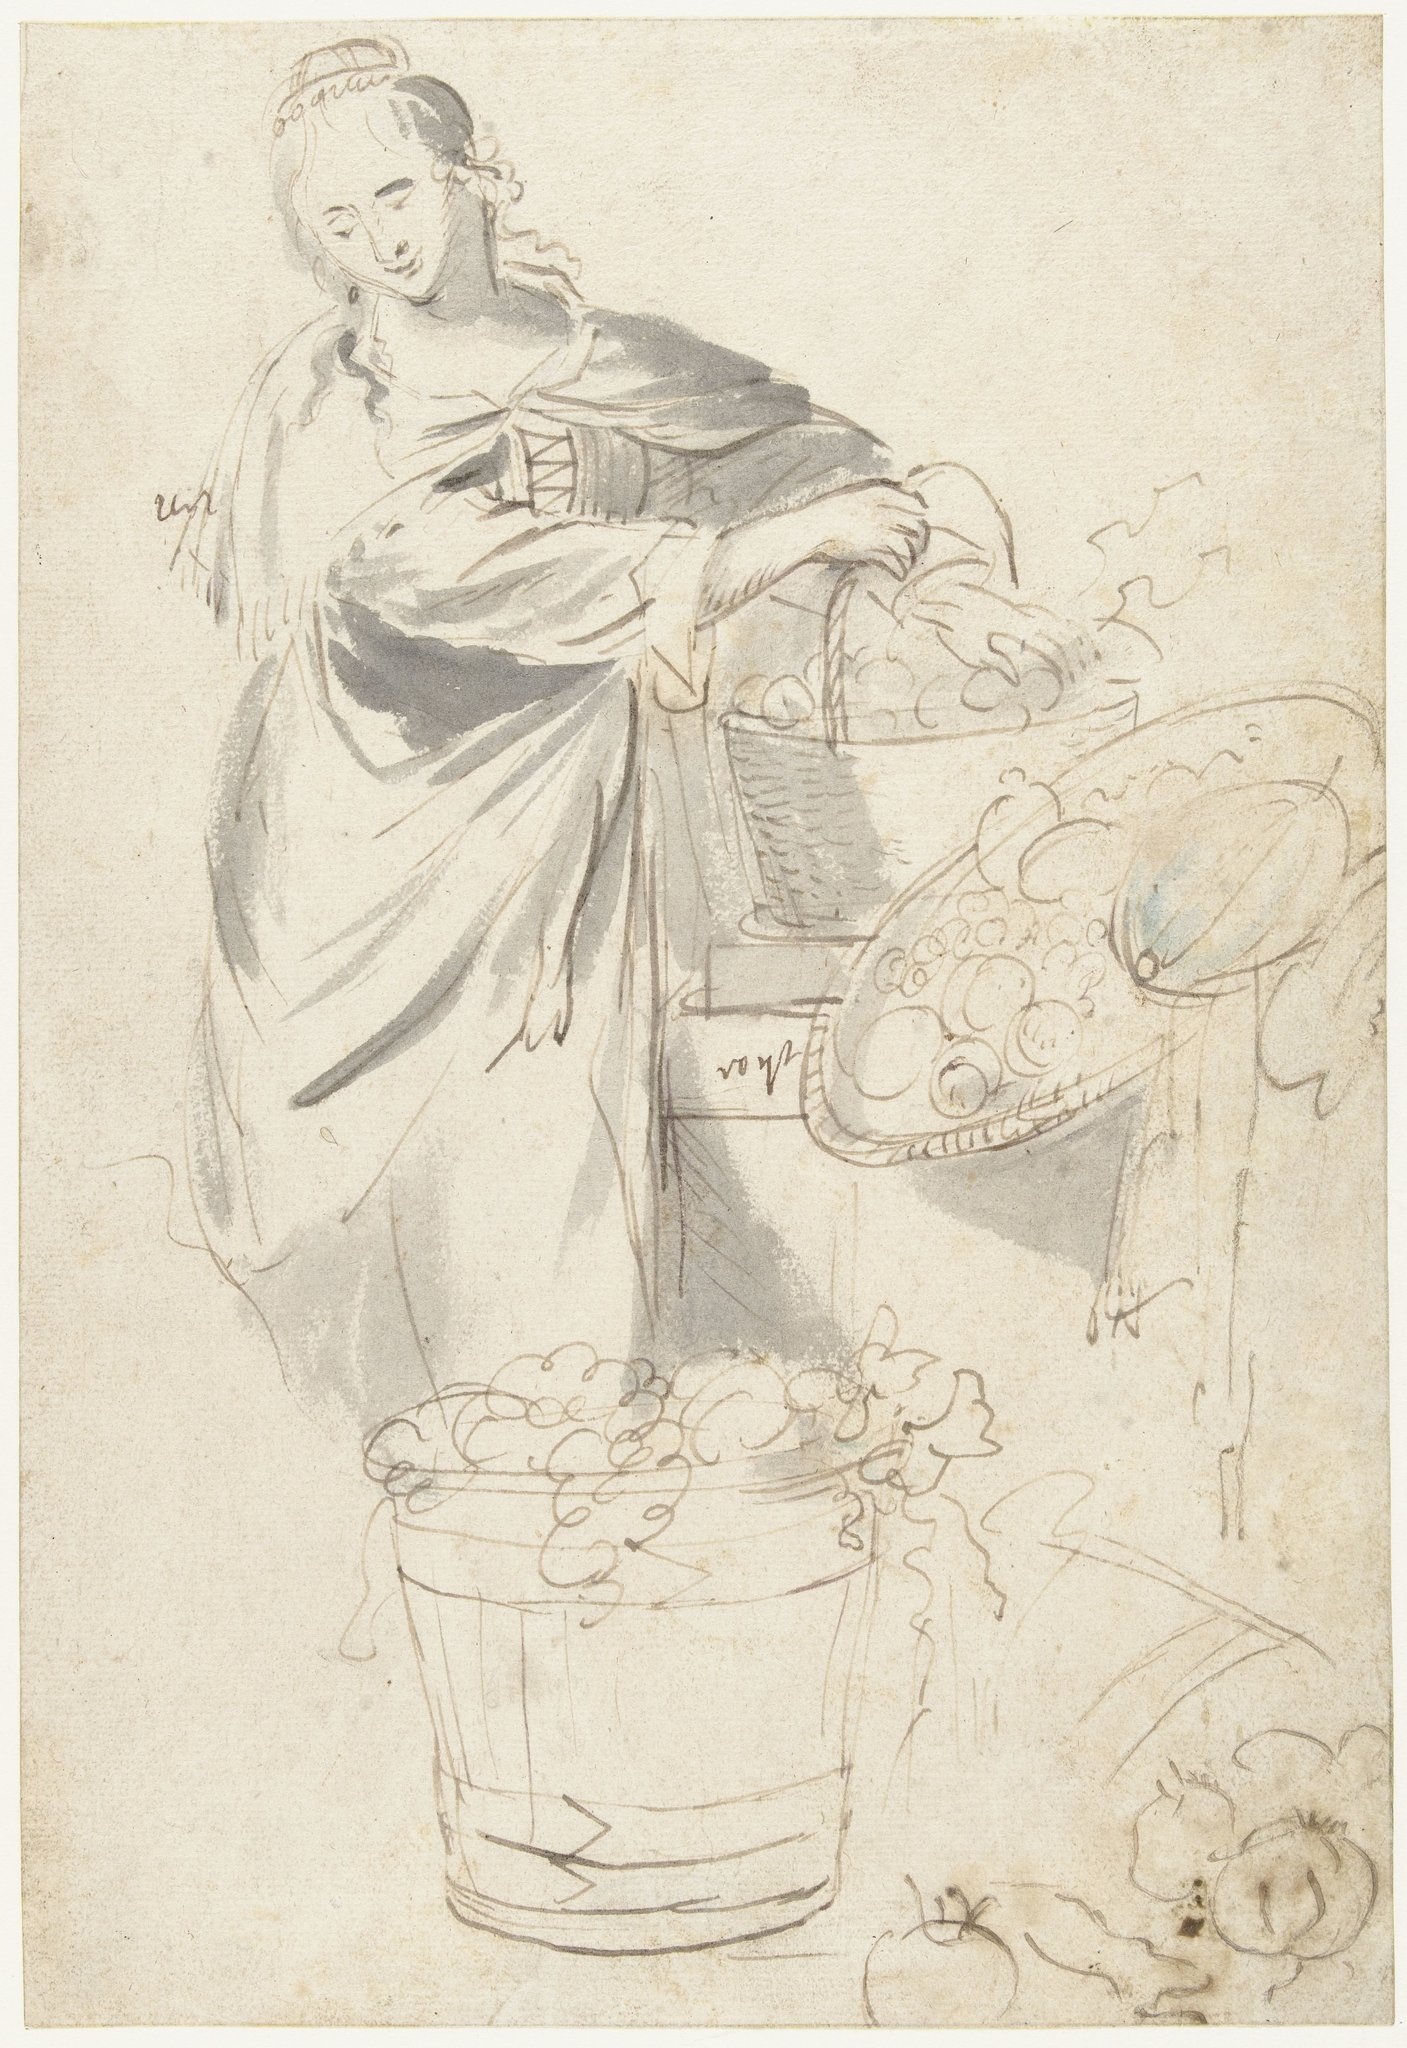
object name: drawing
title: Vrouw staande naast een uitstalling van fruit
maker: frans snijders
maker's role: draughtsman, painter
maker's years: 1579-1657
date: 1589-1657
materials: ink, paper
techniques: brush, pen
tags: street-trader - bb - women engaged in trade and commerce, fruits